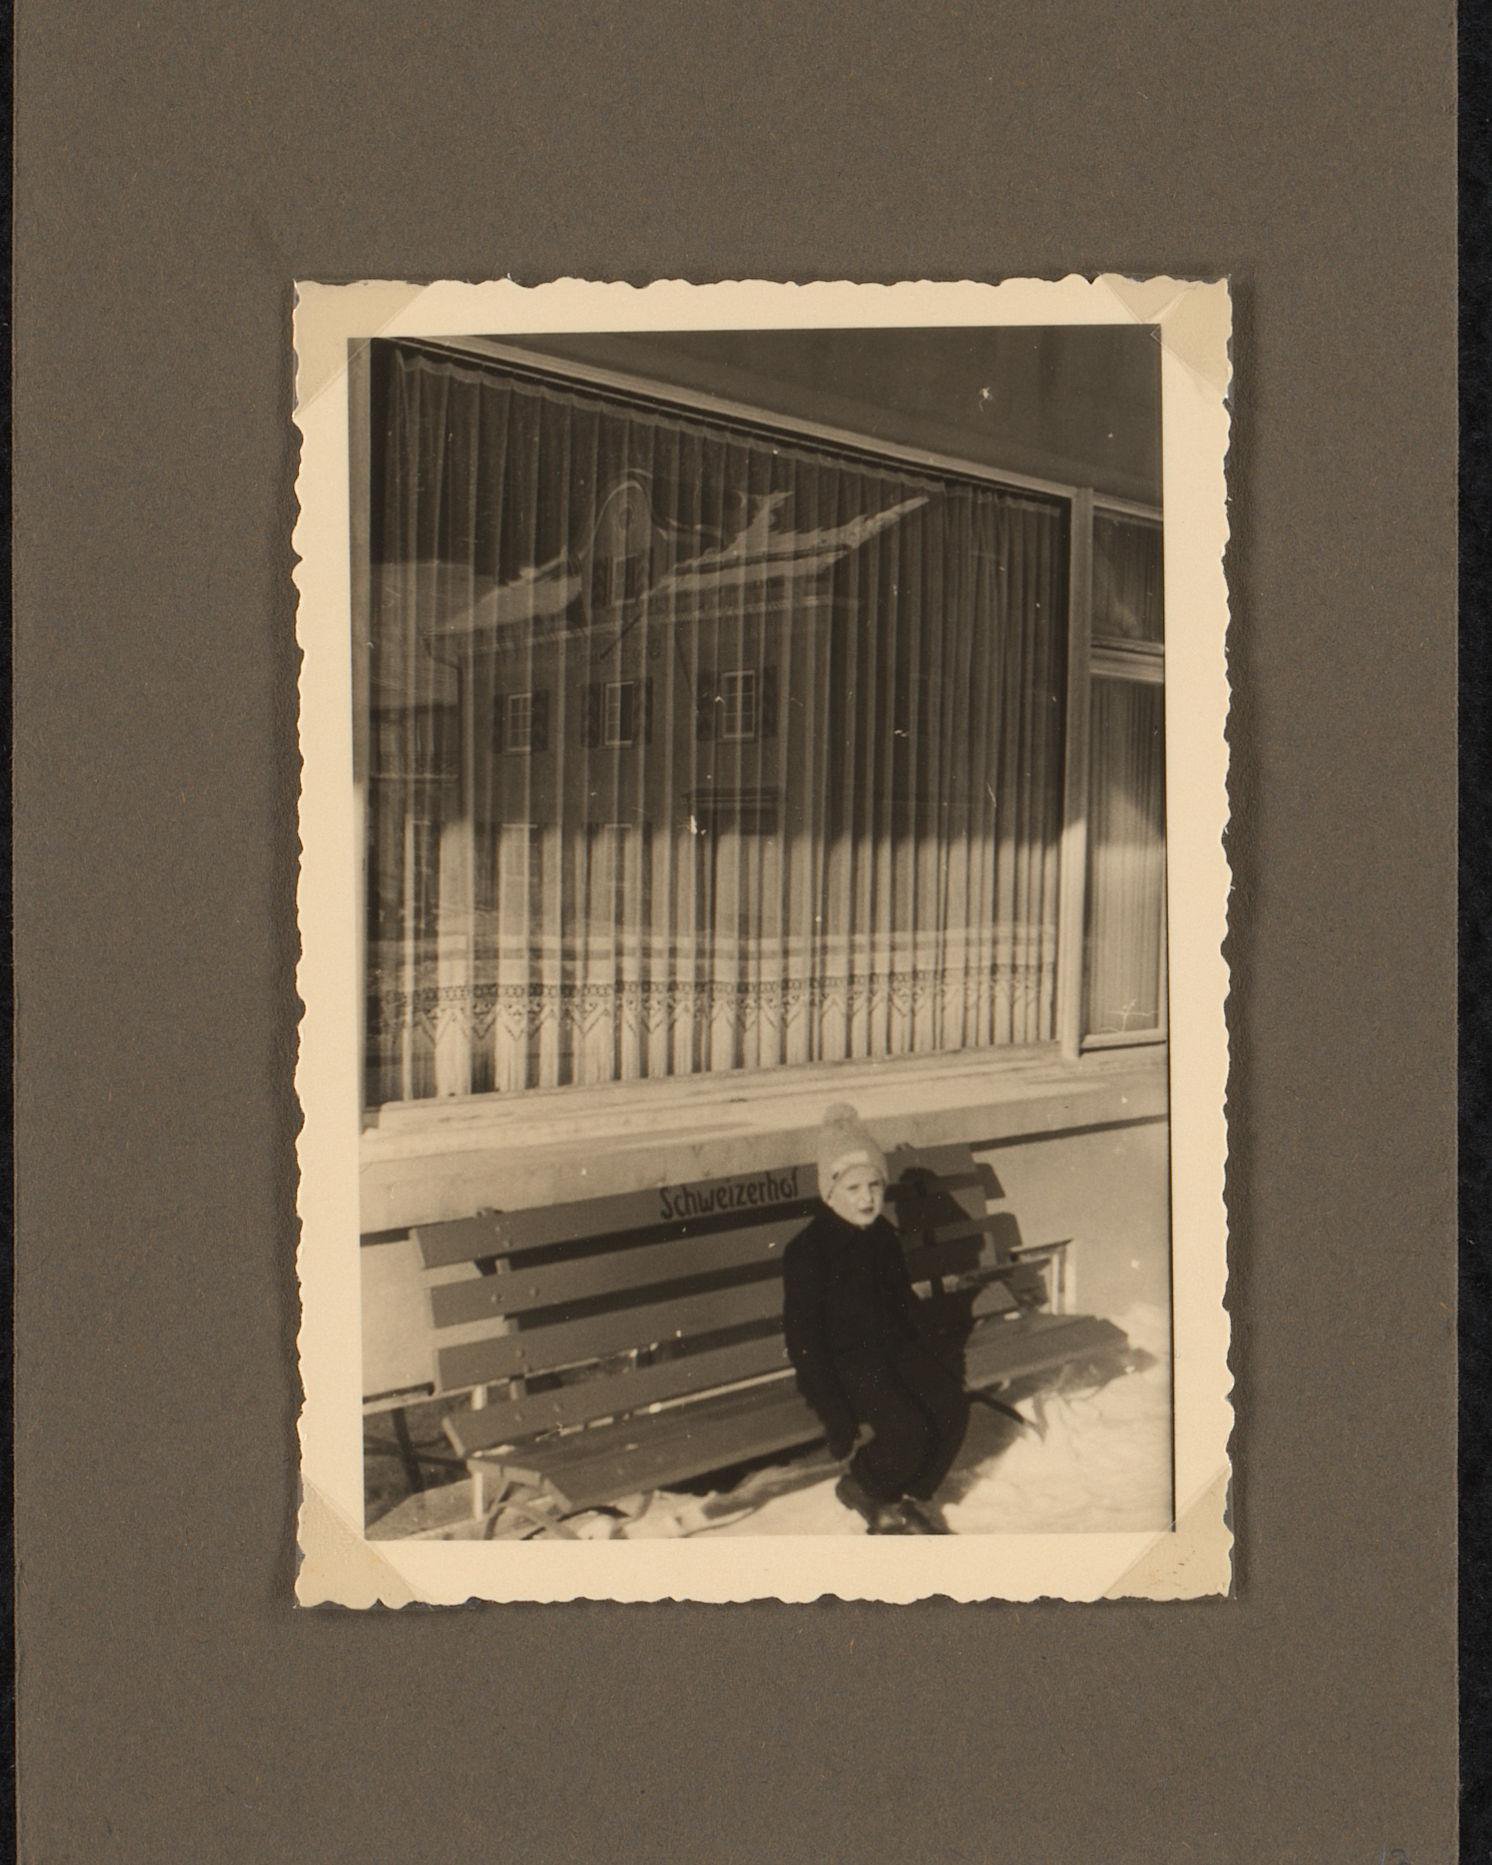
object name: photograph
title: Isabel op een bankje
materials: cardboard, photographic support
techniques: gelatin silver print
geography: lenzerheide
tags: leiden, isabel wachenheimer-elon, the family travelling, on holiday, snow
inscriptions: date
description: Albumblad met een foto van Isabel Wachenheimer op een bankje in de sneeuw. Onderdeel van het fotoalbum met vakantiefoto's Lenzerheide, 1934.